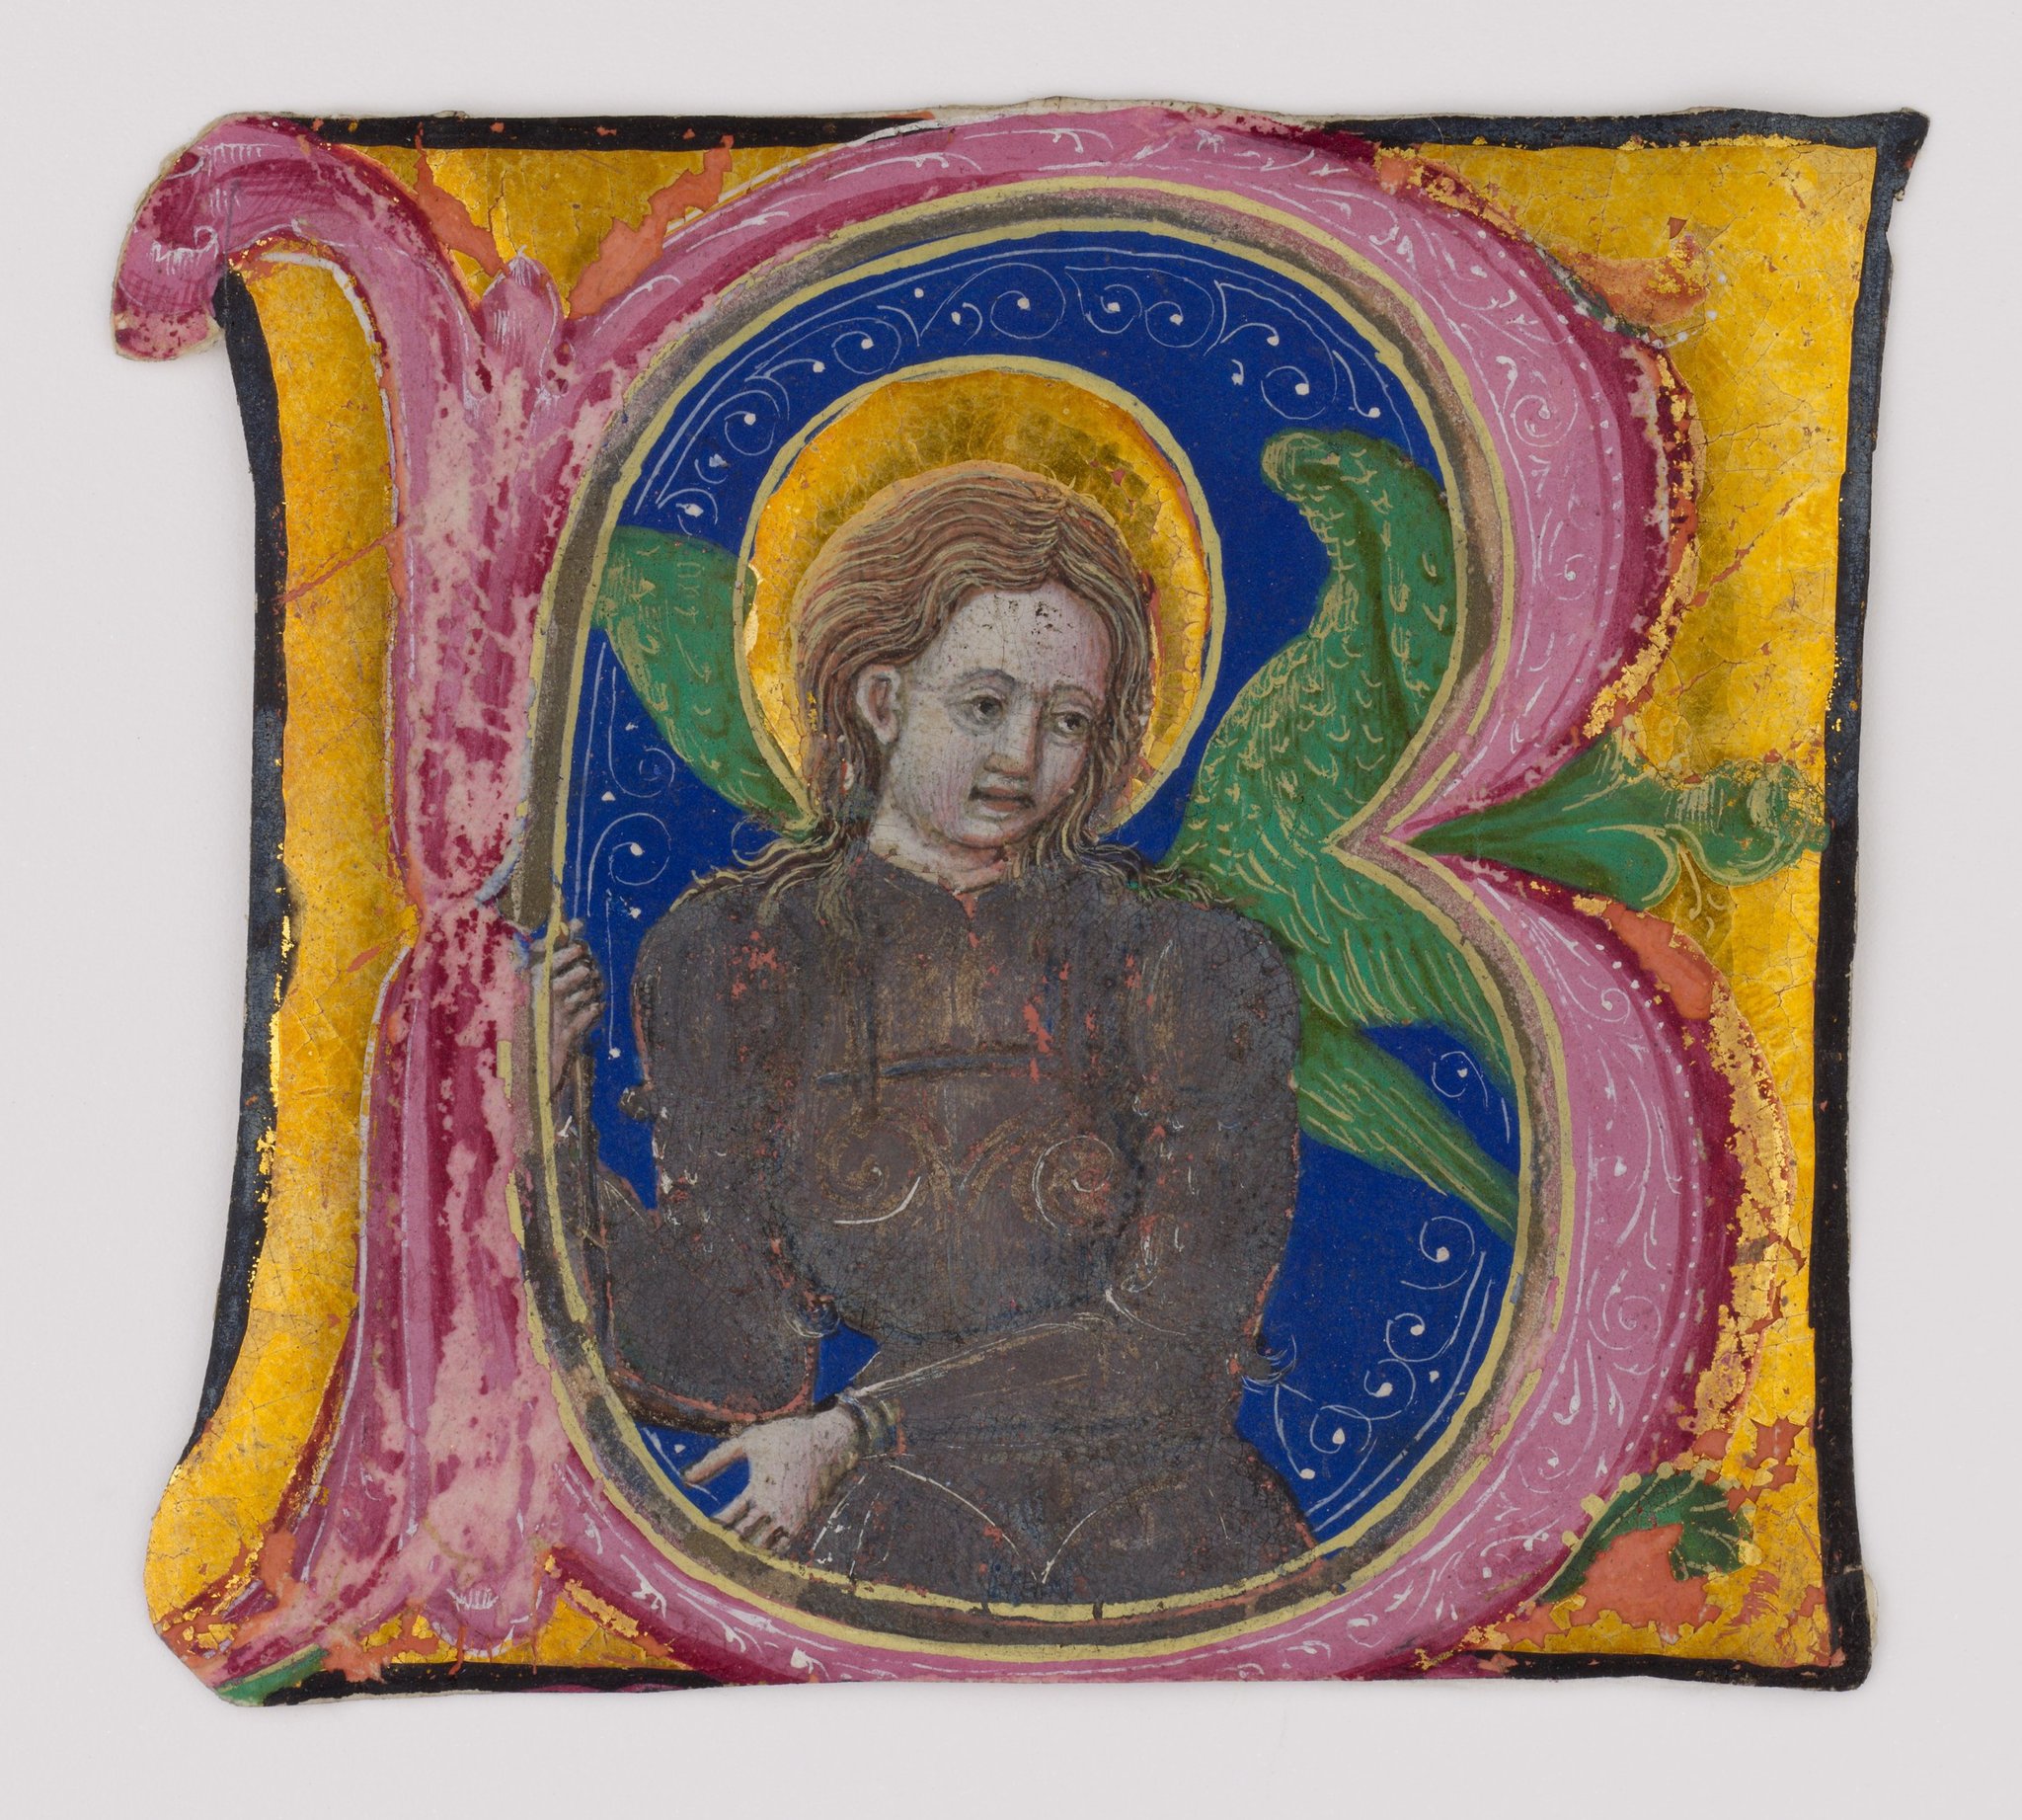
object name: manuscript leaf cutting from a choir book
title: Manuscript Leaf Cutting from a Choir Book with an Illuminated Initial B and the Archangel Michael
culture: italian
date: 1451-1500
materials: gold, ink, parchment, silver, paint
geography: italy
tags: women